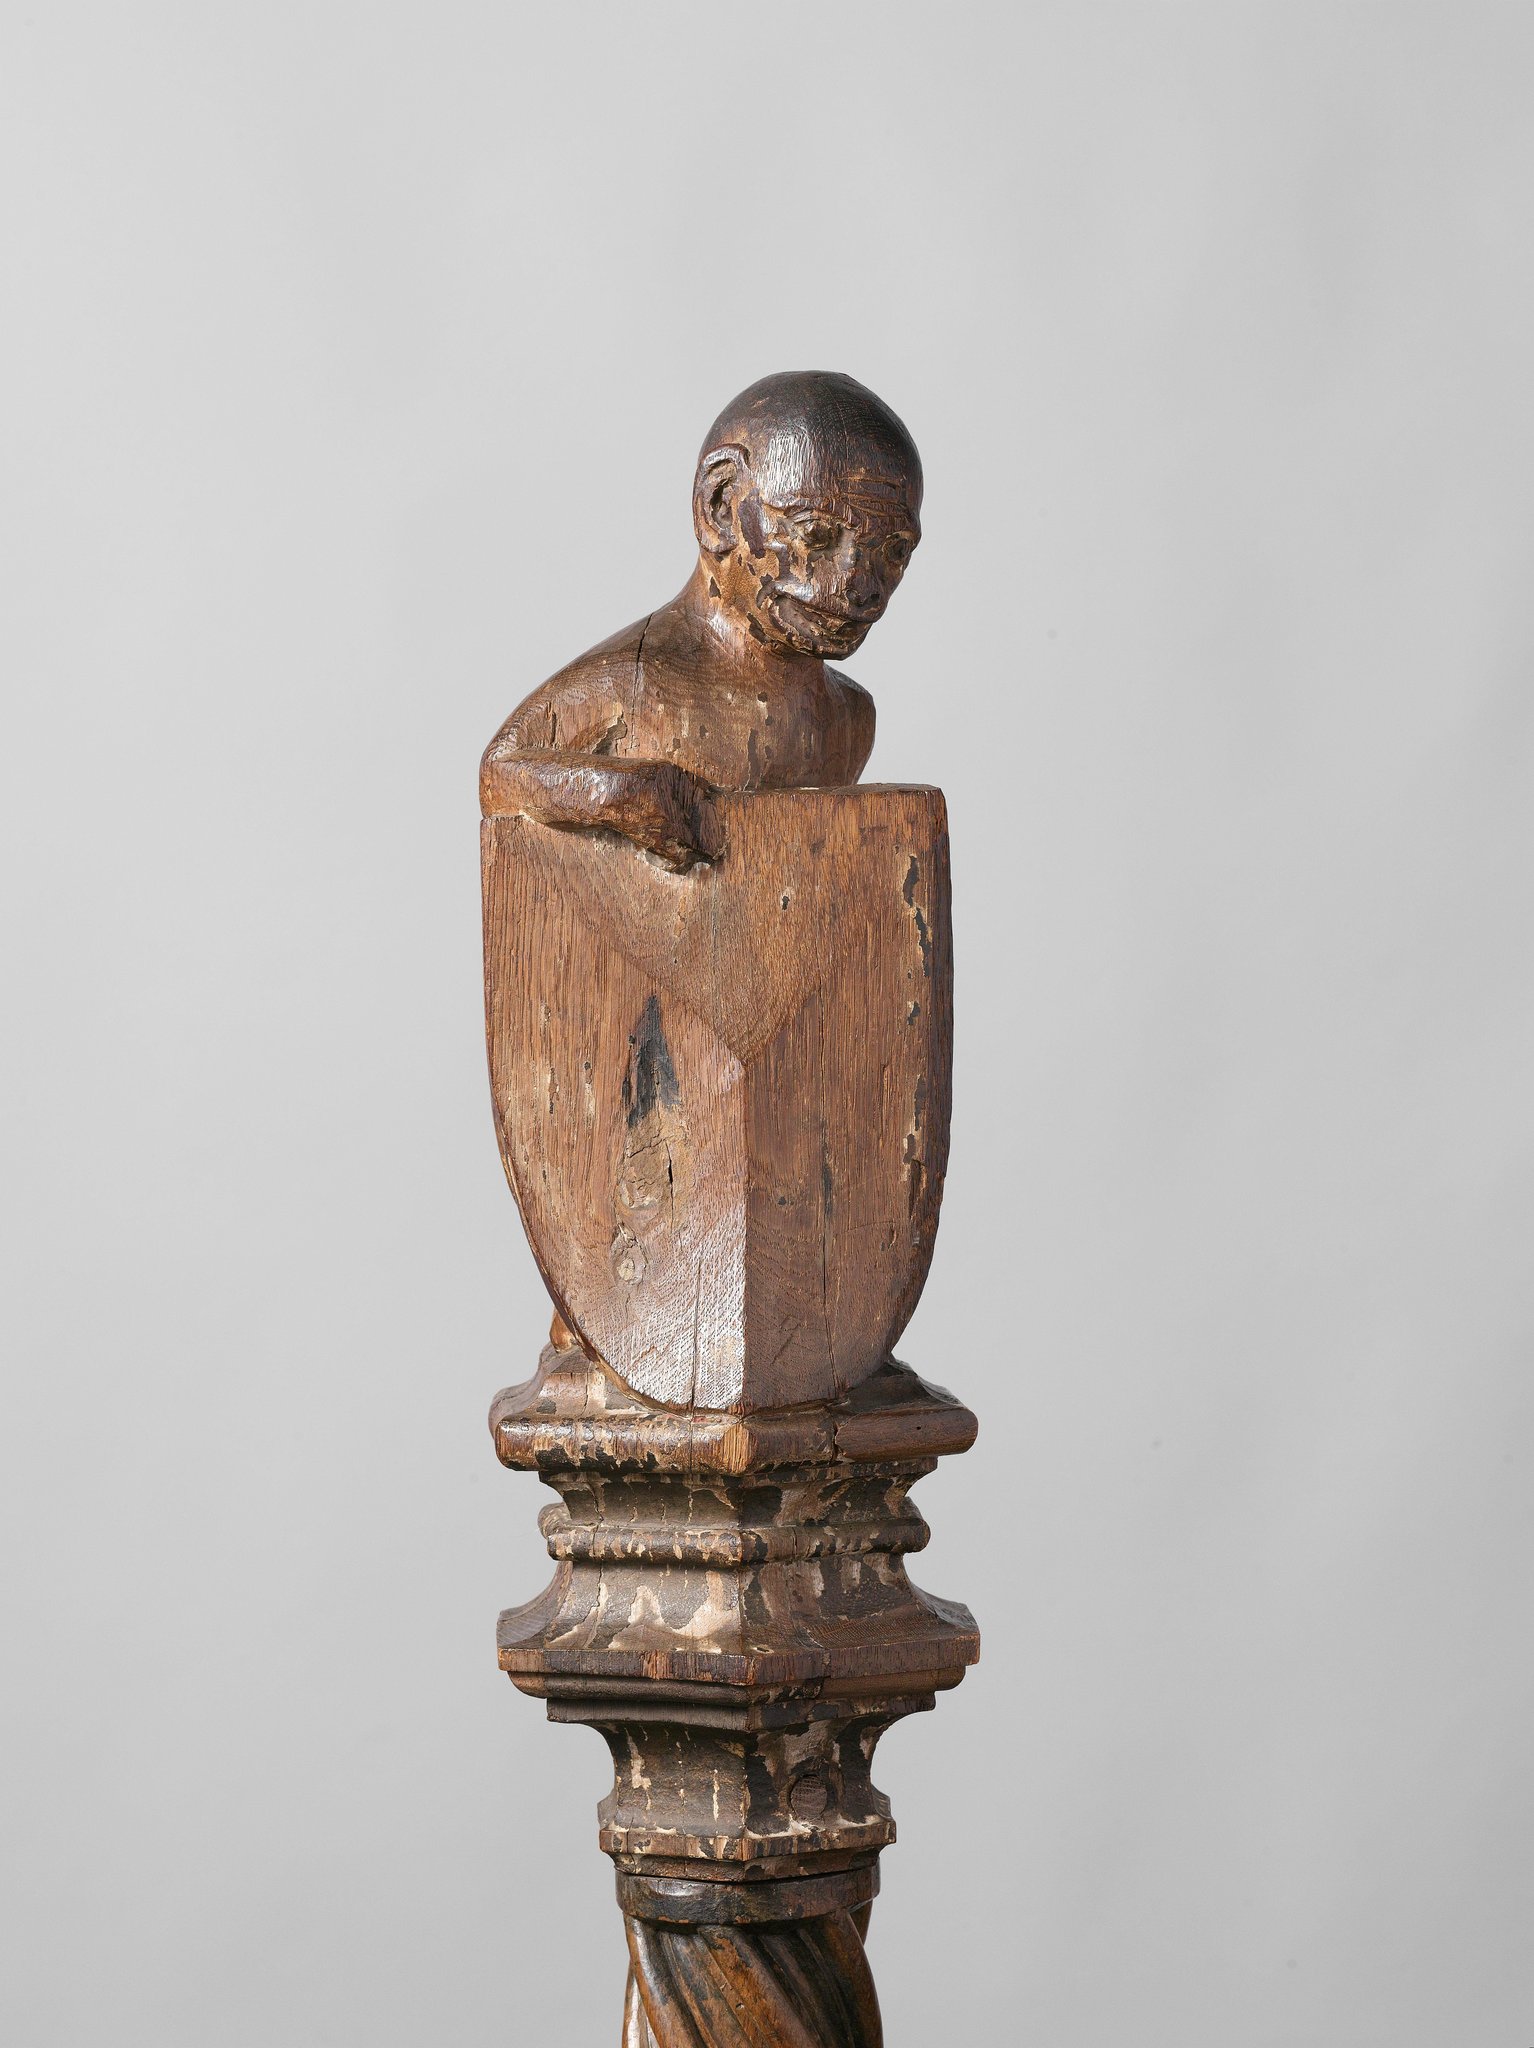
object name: sculpture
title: Monkey Supporting an Escutcheon, from the Top of a Balustrade or the Backrest of the Stadholder’s Chair in the Rolzaal in the Hof van Holland, The Hague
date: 1511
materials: wood, paint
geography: the hague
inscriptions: coat of arms: unrecognizable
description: Beeldhouwwerk van dier of mens met wapenbord, zittend op een zuil. Het beeld hoort bij elf beelden (BK-NM-144-1 t/m BK-NM-144-12).